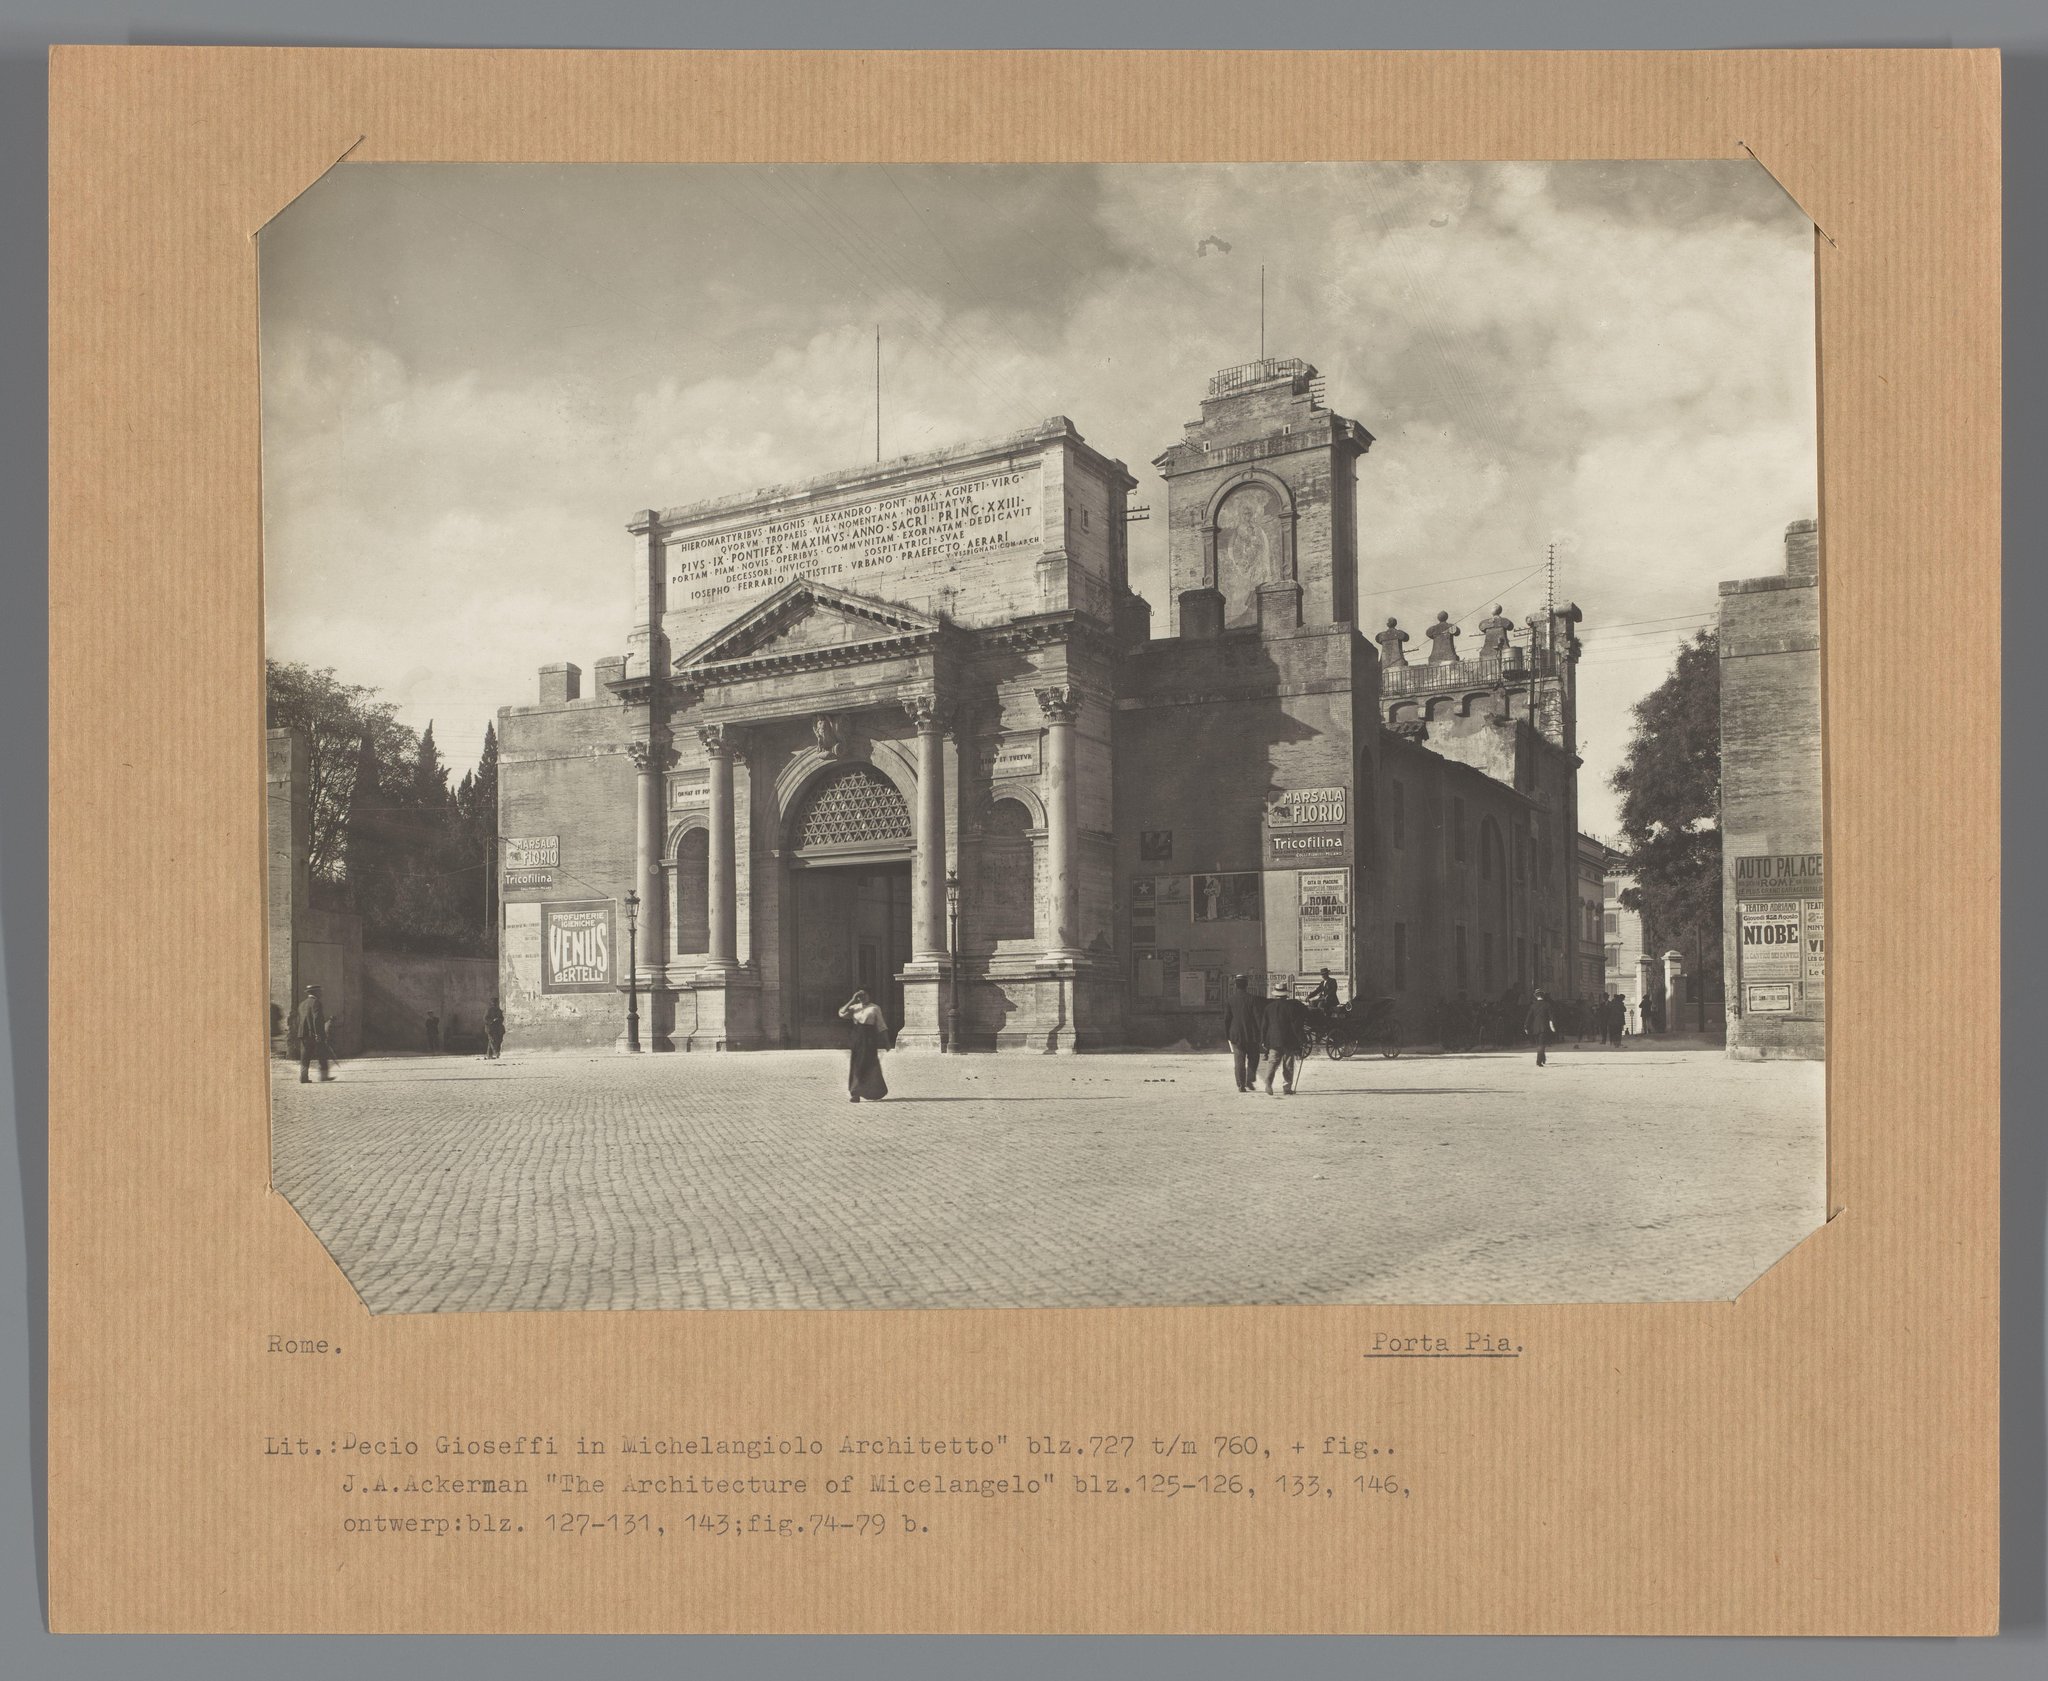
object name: photograph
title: Italië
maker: Anonymous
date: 1880-1910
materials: photographic support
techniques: albumen print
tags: italy